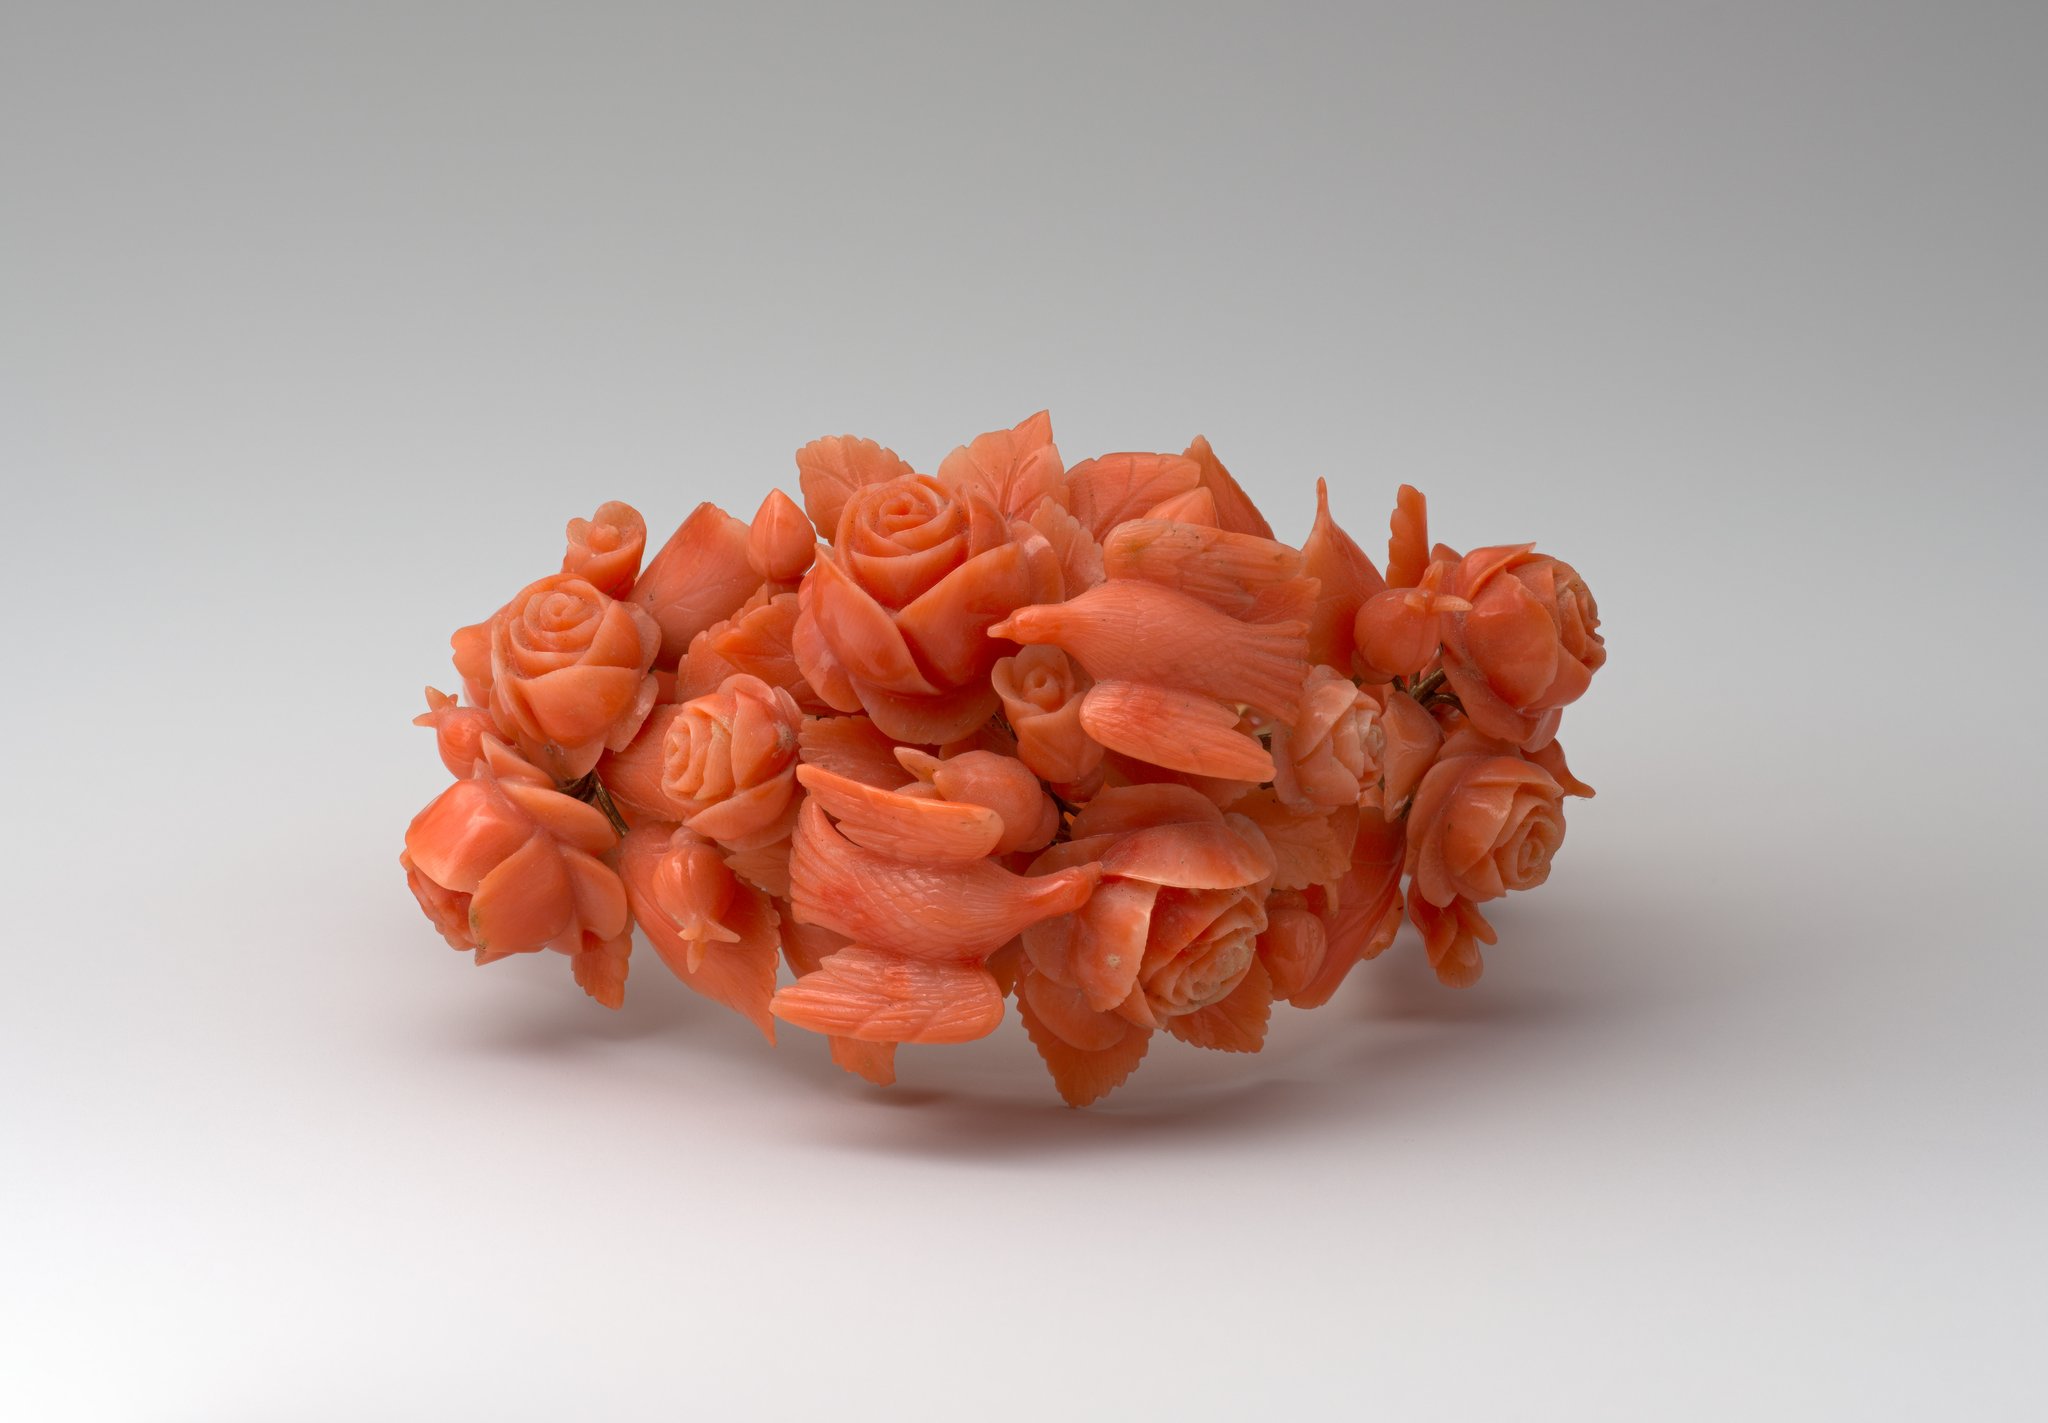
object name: bracelet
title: Bracelet (part of parure)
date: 1860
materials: coral, gold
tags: birds